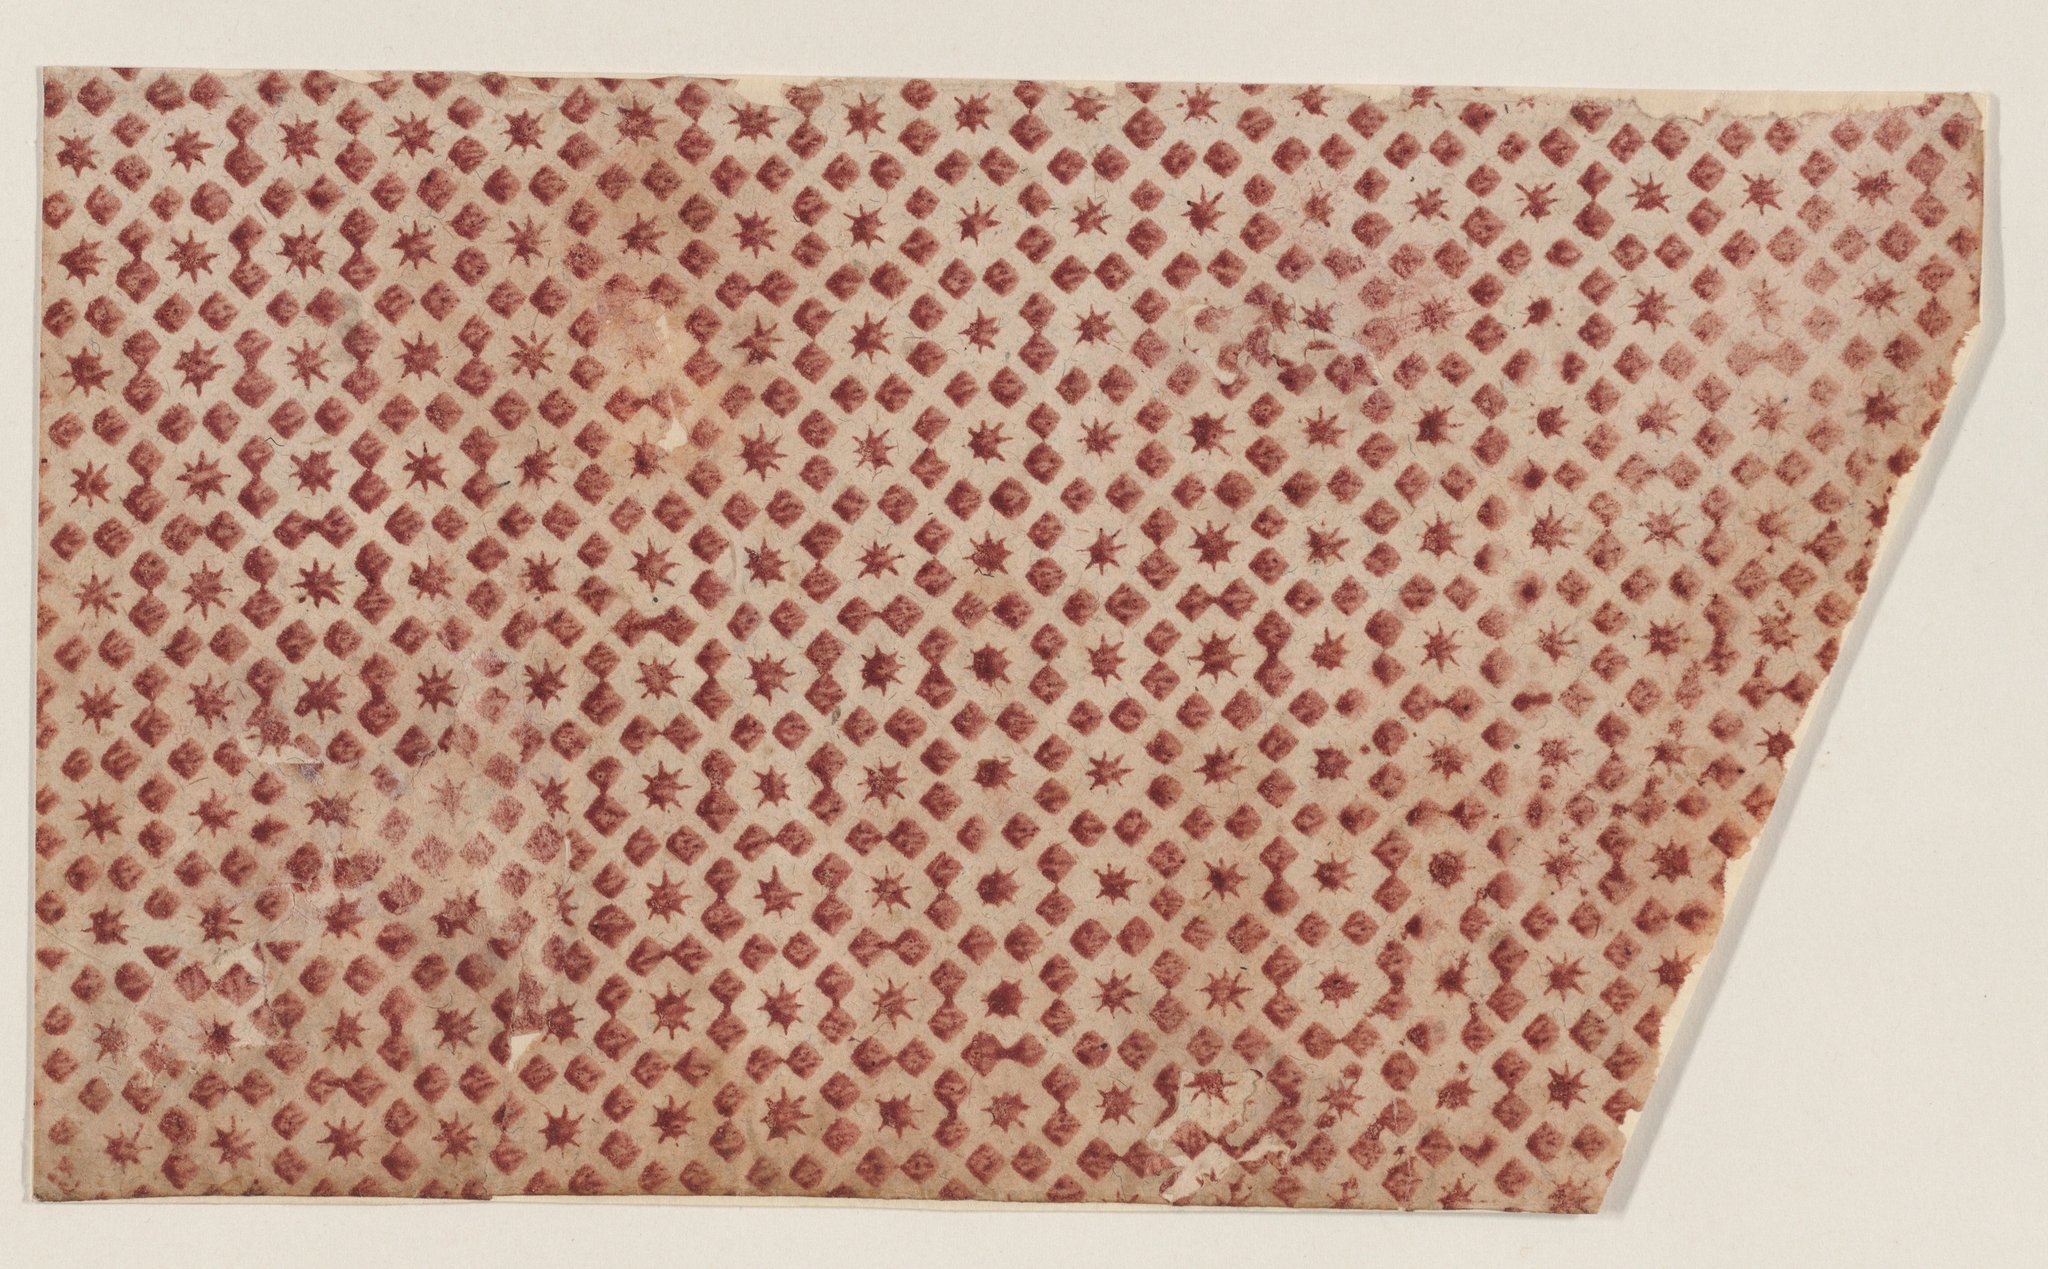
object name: print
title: Sheet with overall geometric pattern with squares and stars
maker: Anonymous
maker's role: artist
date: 1801-1900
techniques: relief print